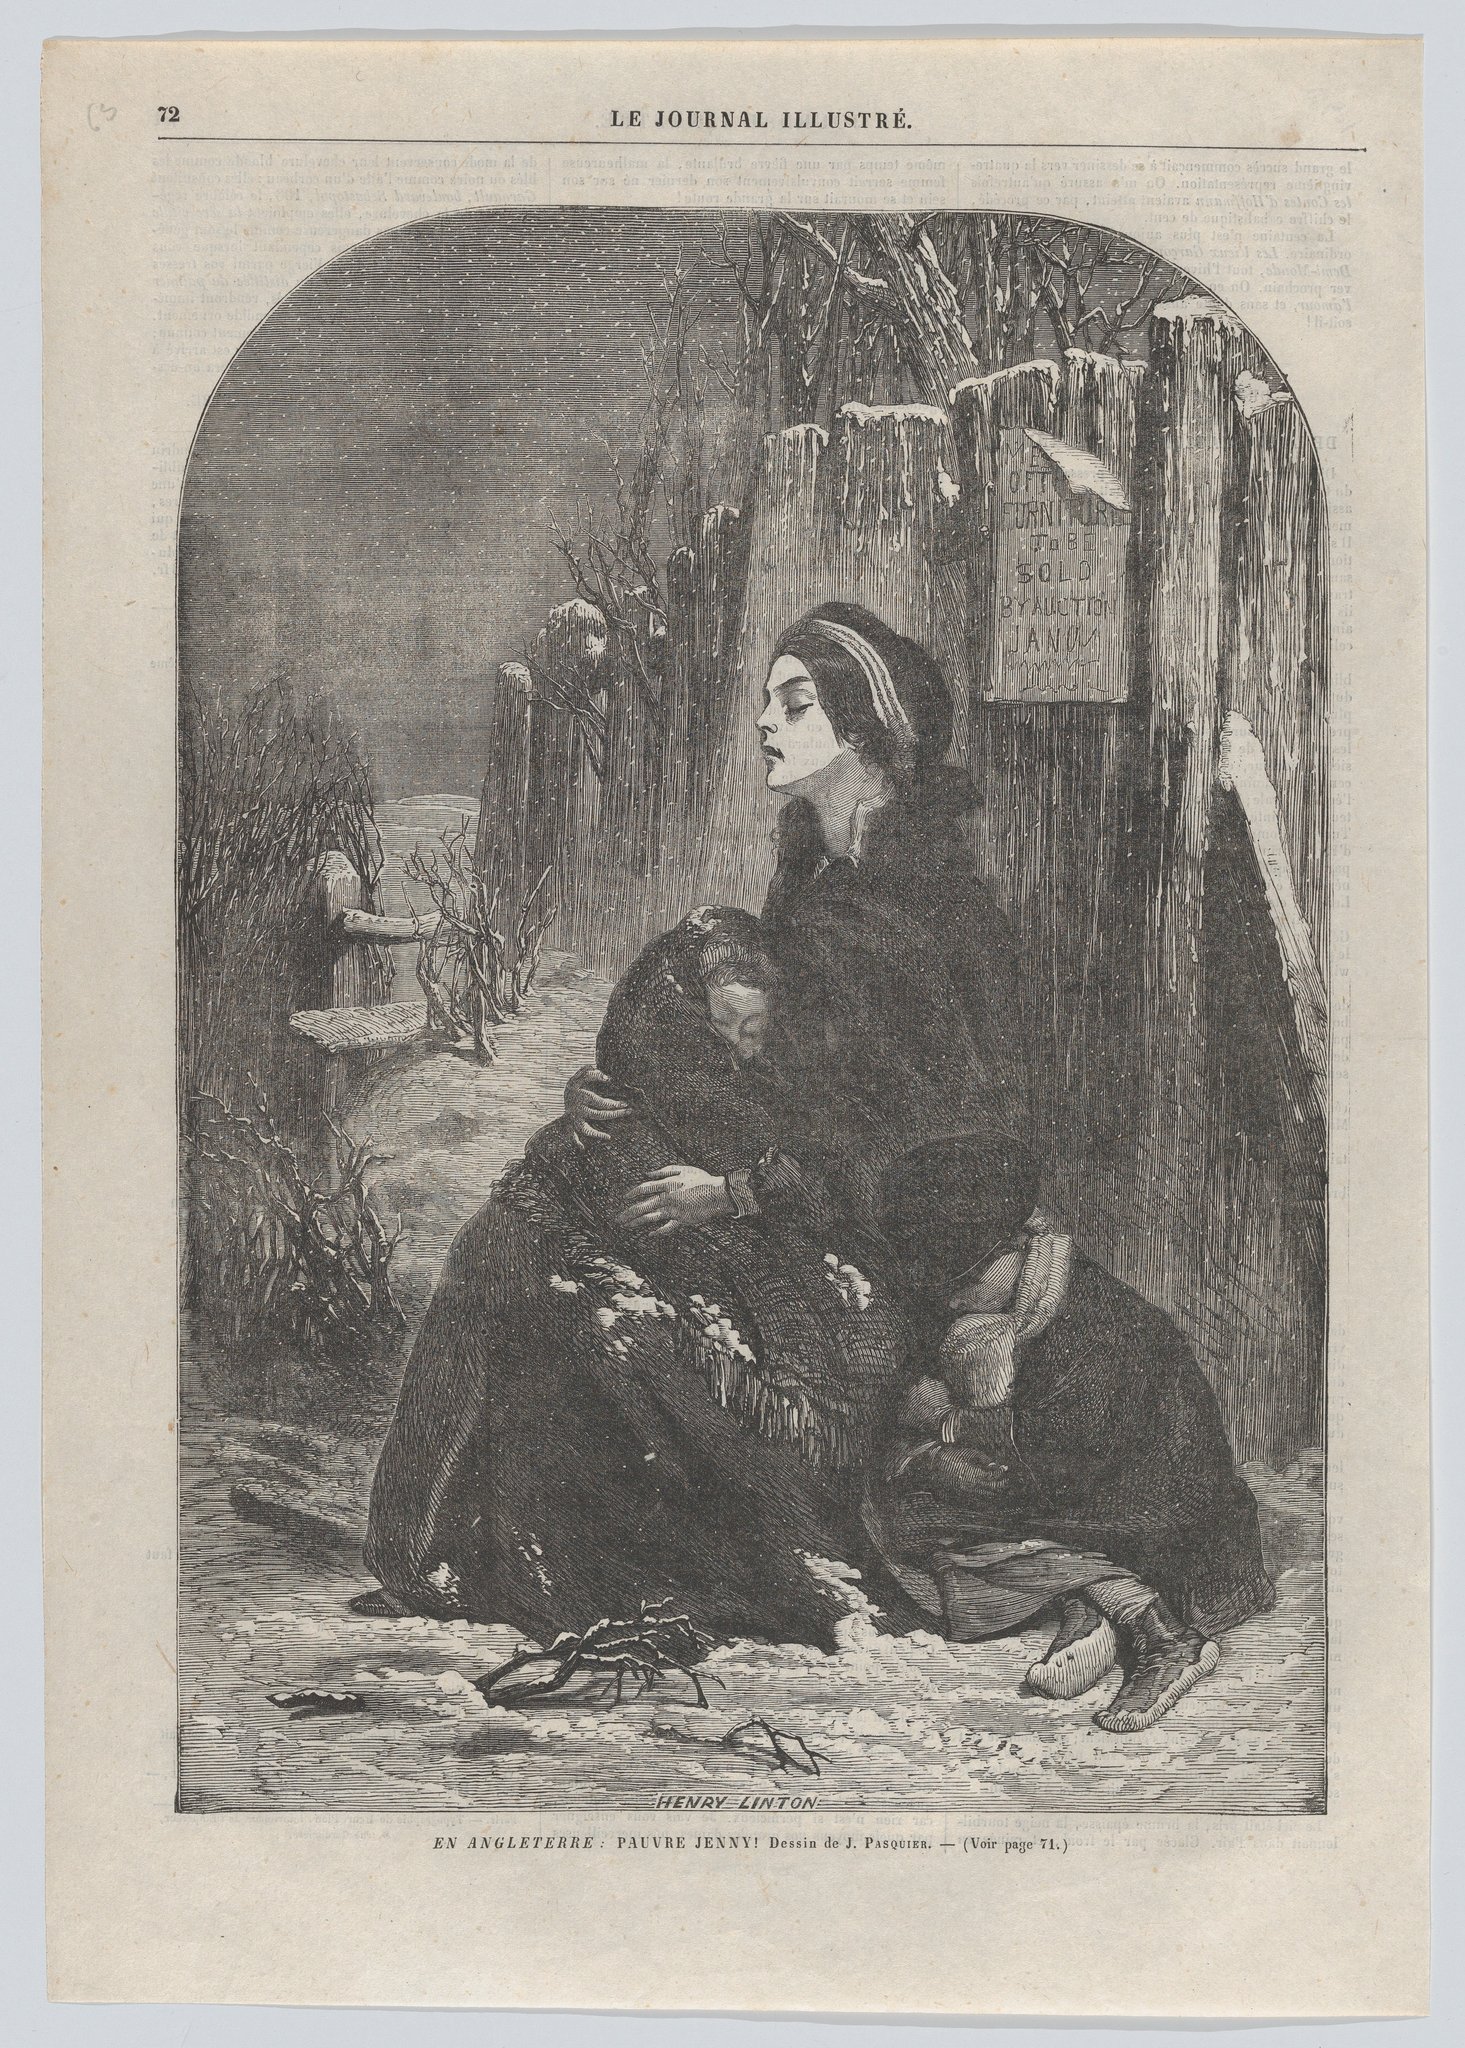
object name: print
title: En Angleterre: Pauvre Jenny!, from "Le Journal Illustré," no. 55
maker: henry linton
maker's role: engraver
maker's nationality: british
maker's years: 1815-1899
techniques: engraving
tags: children,women,winter,snow